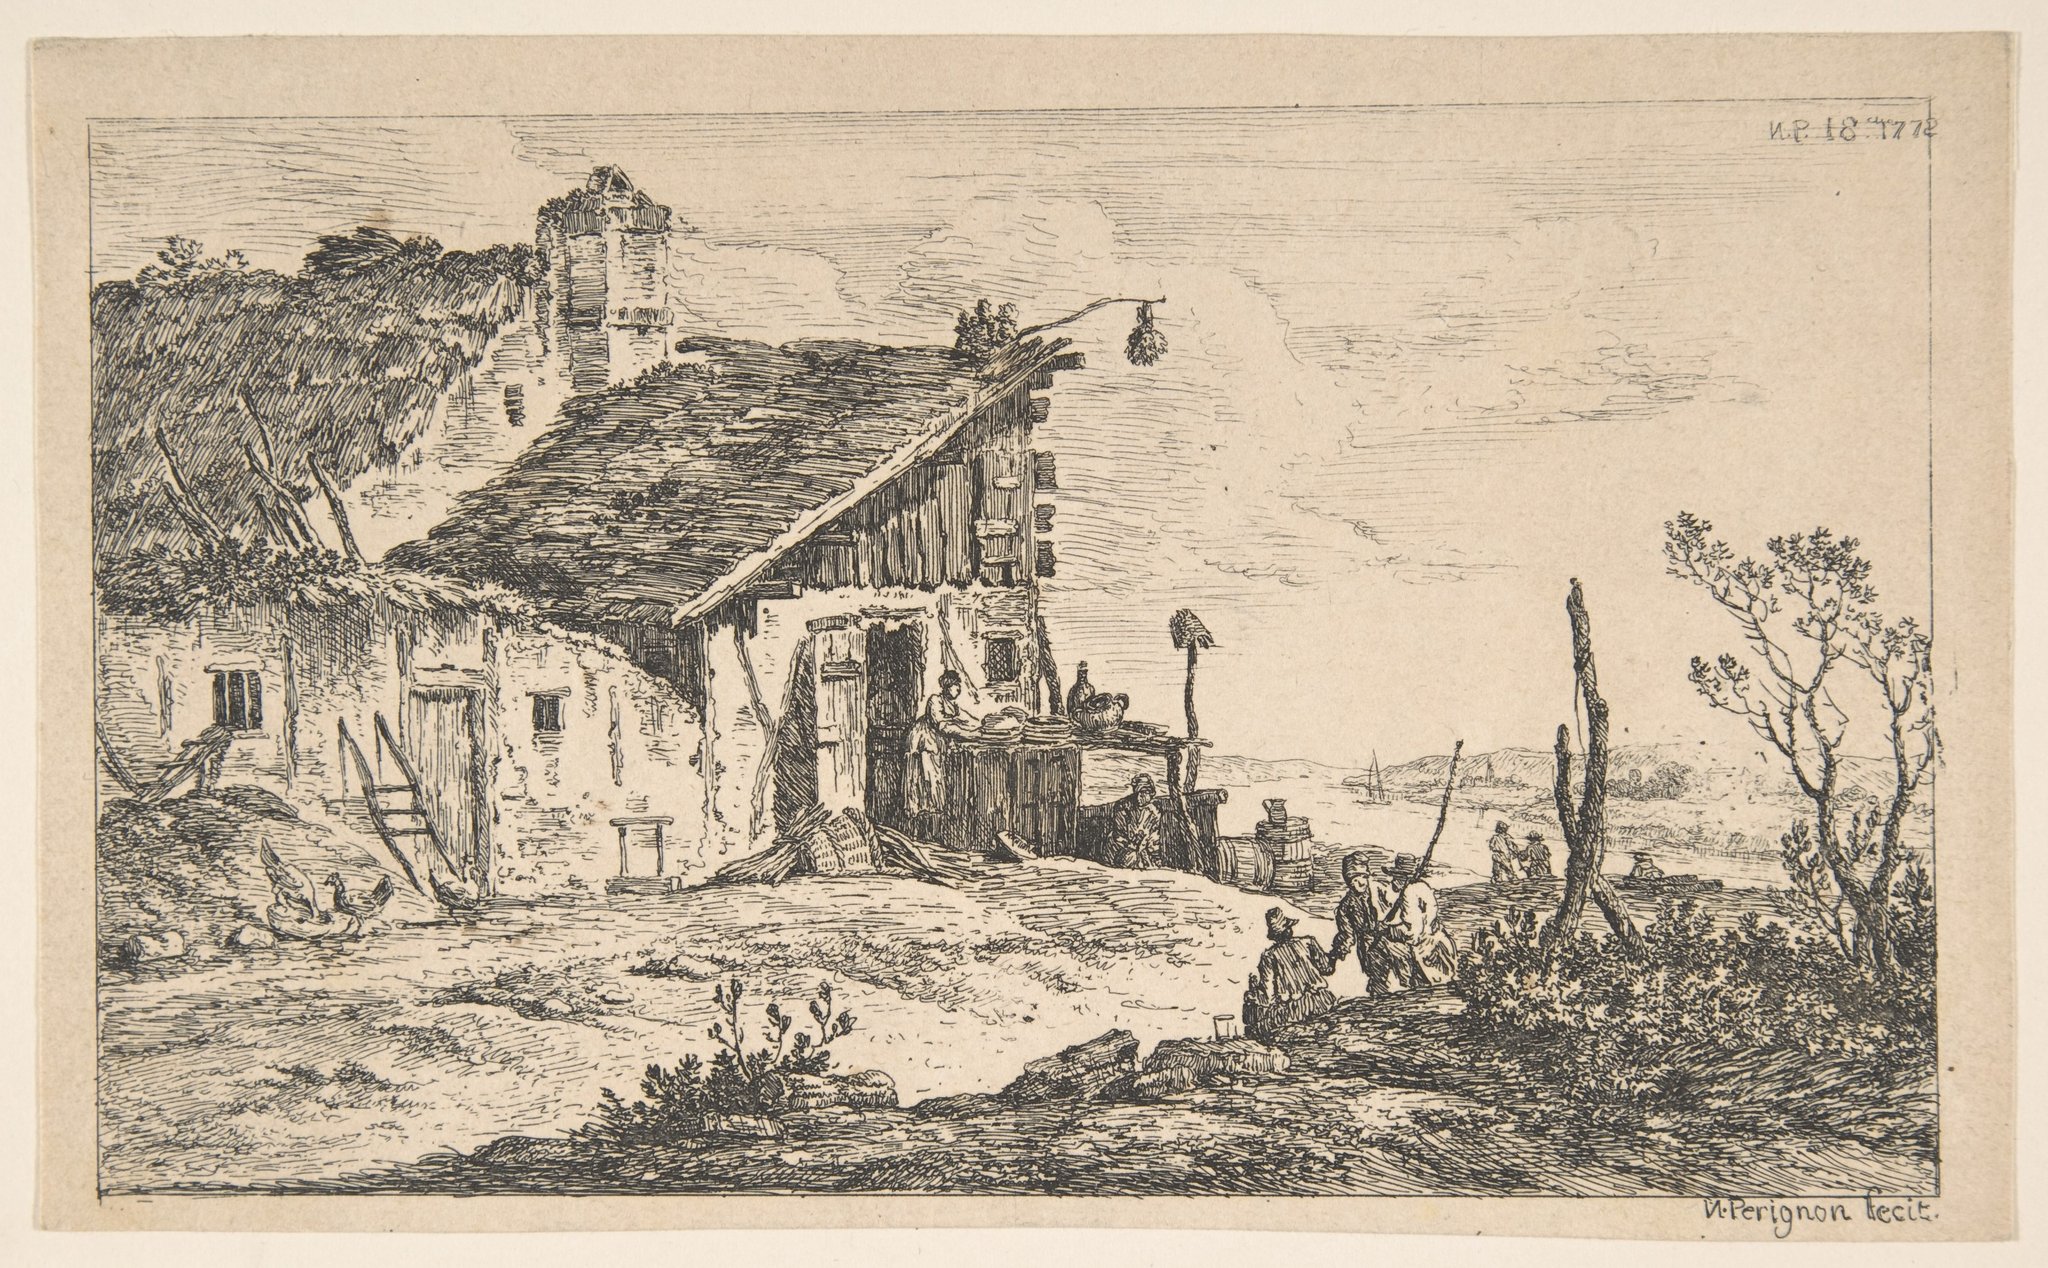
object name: print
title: Rustic Landscape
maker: nicolas pérignon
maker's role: artist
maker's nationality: french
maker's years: 1726-1782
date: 1772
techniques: etching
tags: human figures,houses,landscapes